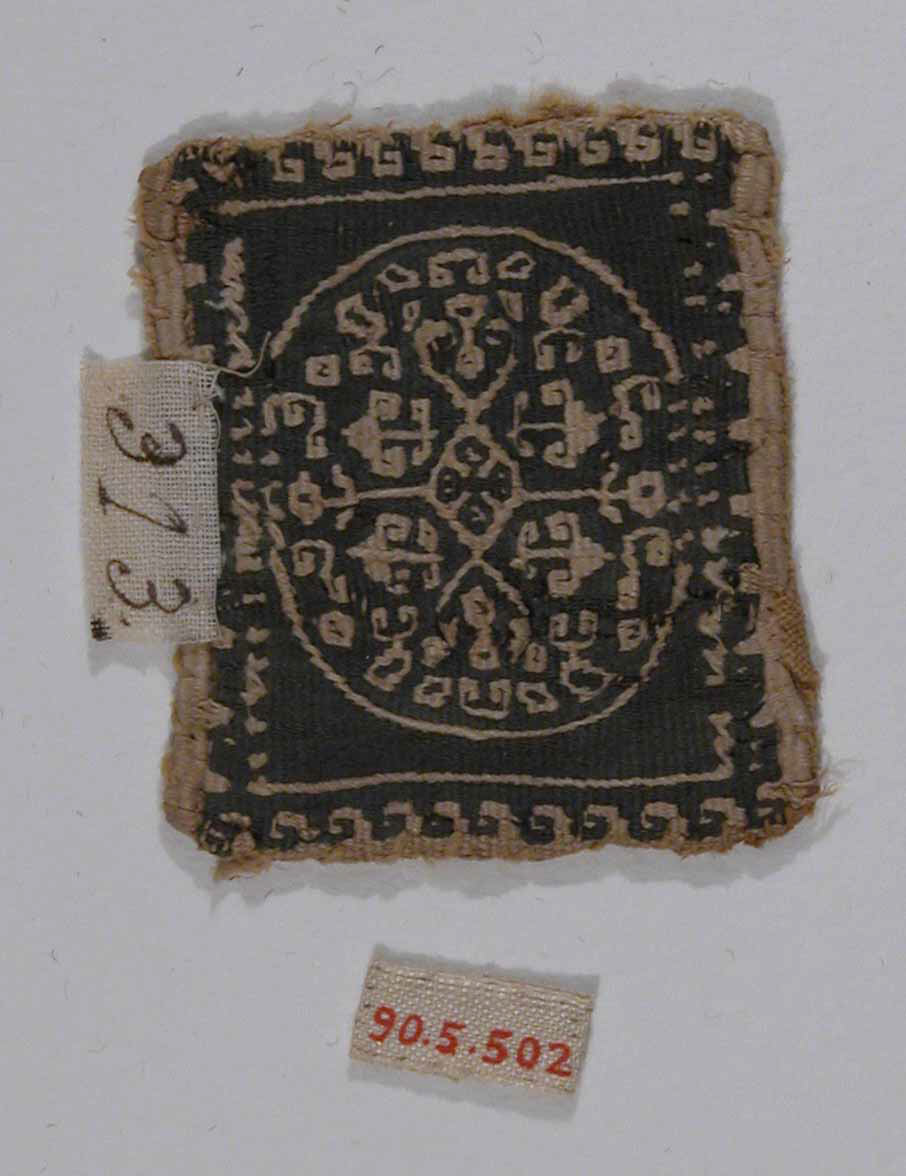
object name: textile fragment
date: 301-400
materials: linen, wool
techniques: weave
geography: egypt